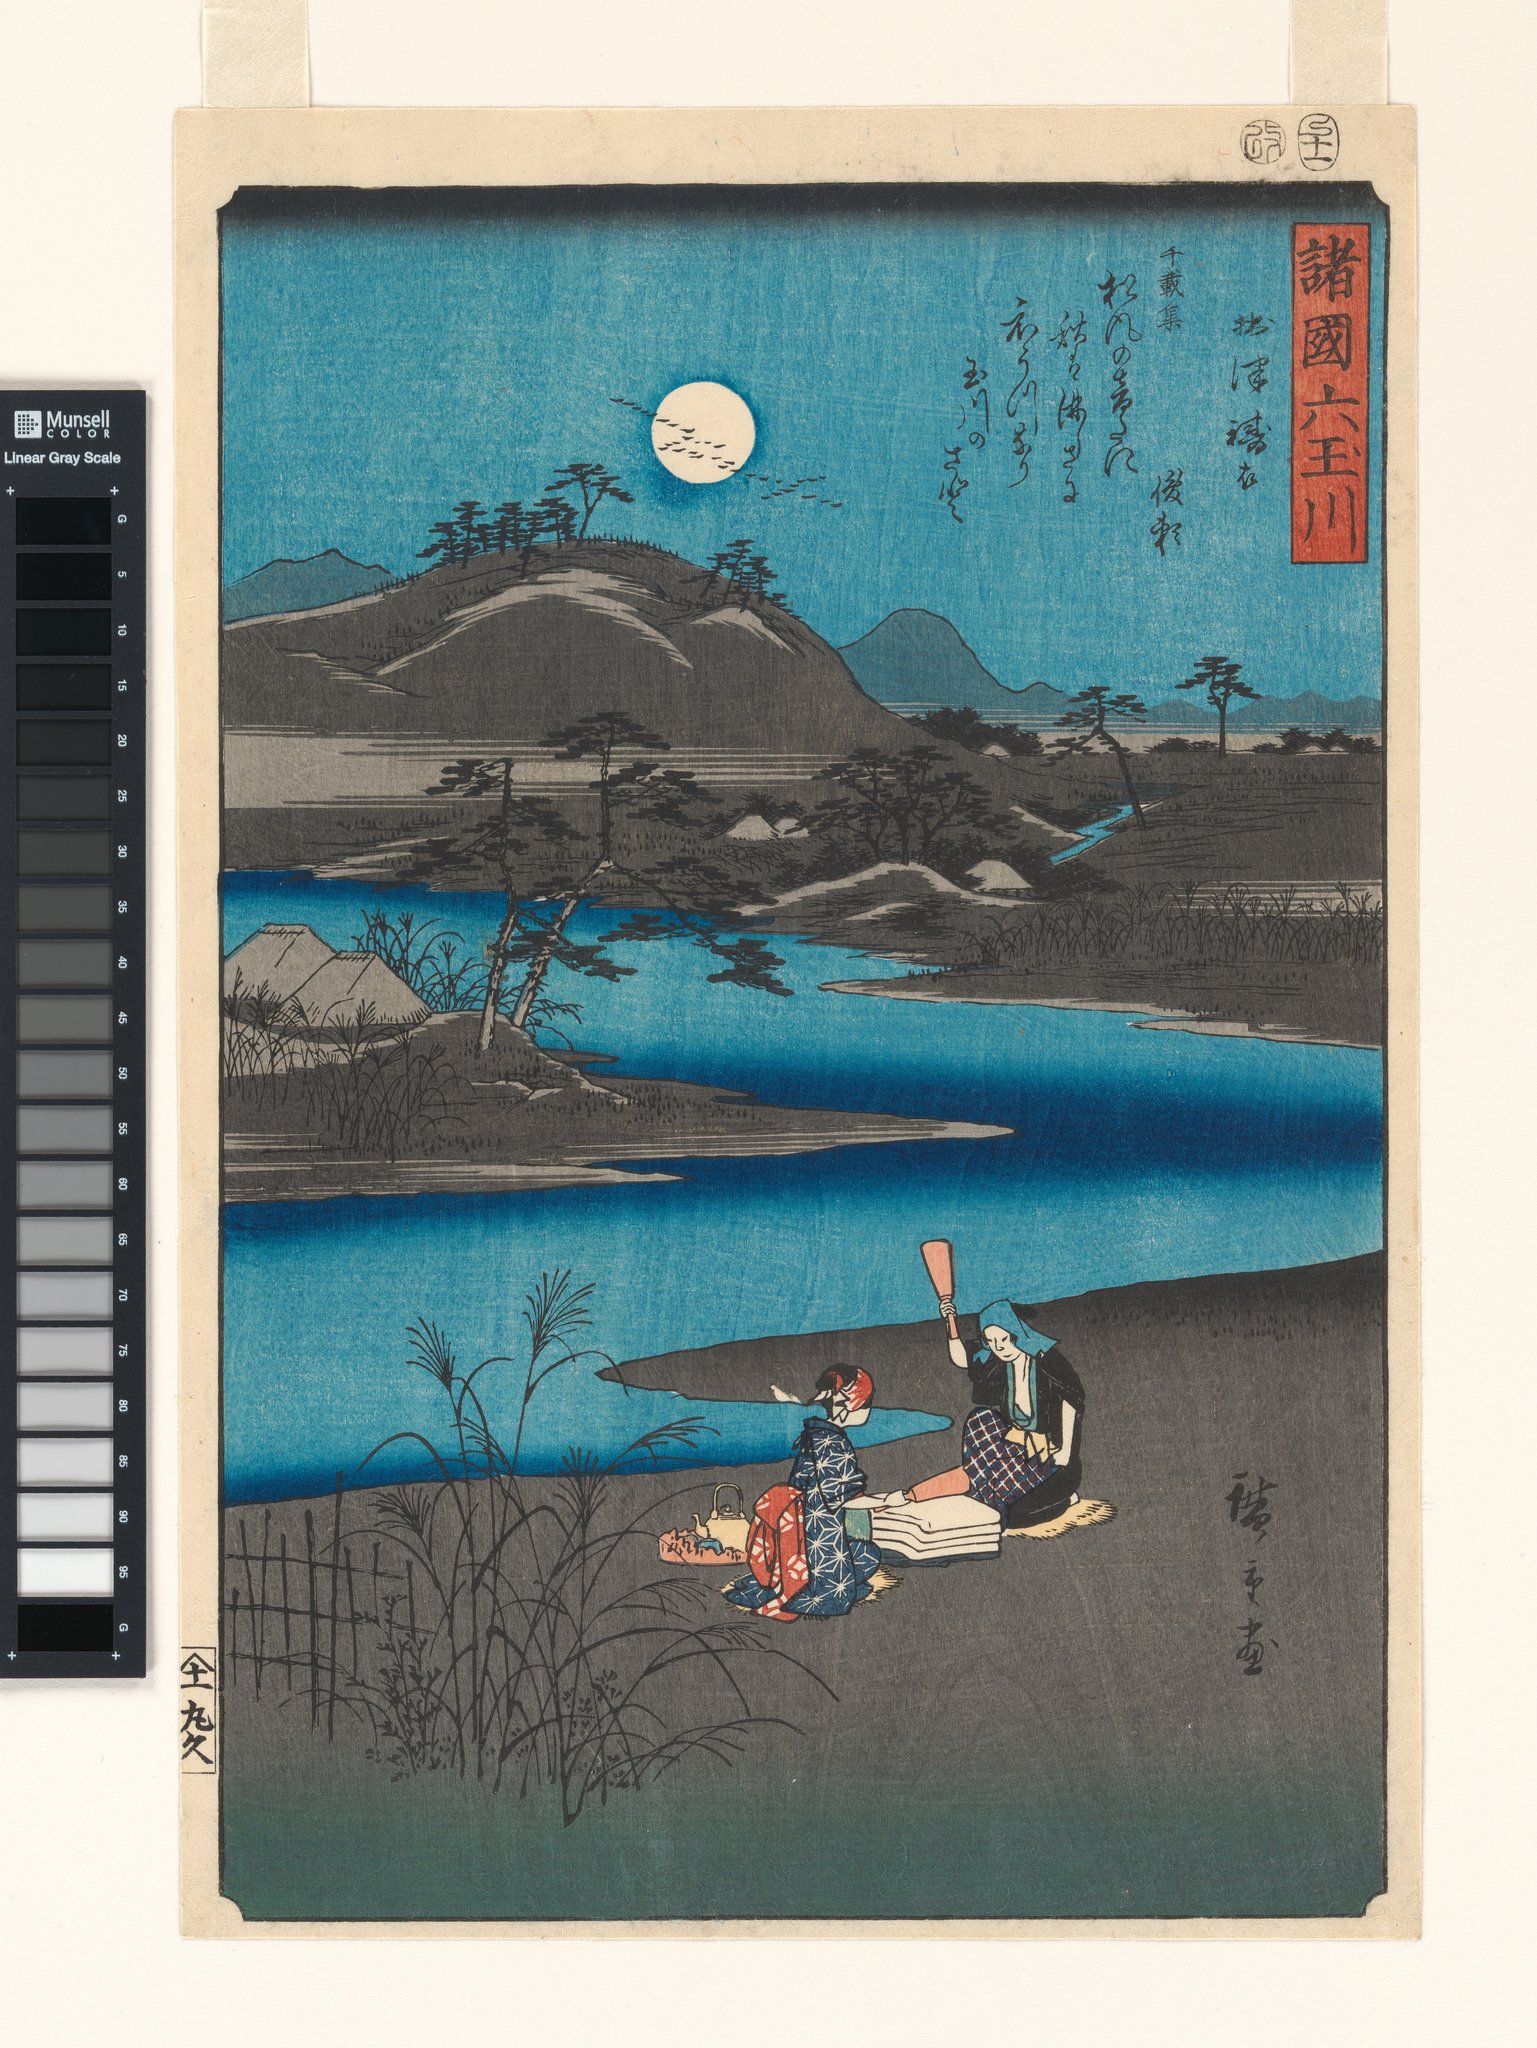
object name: print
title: Six Jewel Rivers from Various Provinces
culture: japanese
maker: utagawa hiroshige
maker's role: artist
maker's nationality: japanese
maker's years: 1797-1858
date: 1857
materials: ink, paper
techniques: woodblock print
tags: women,rivers,moon,landscapes